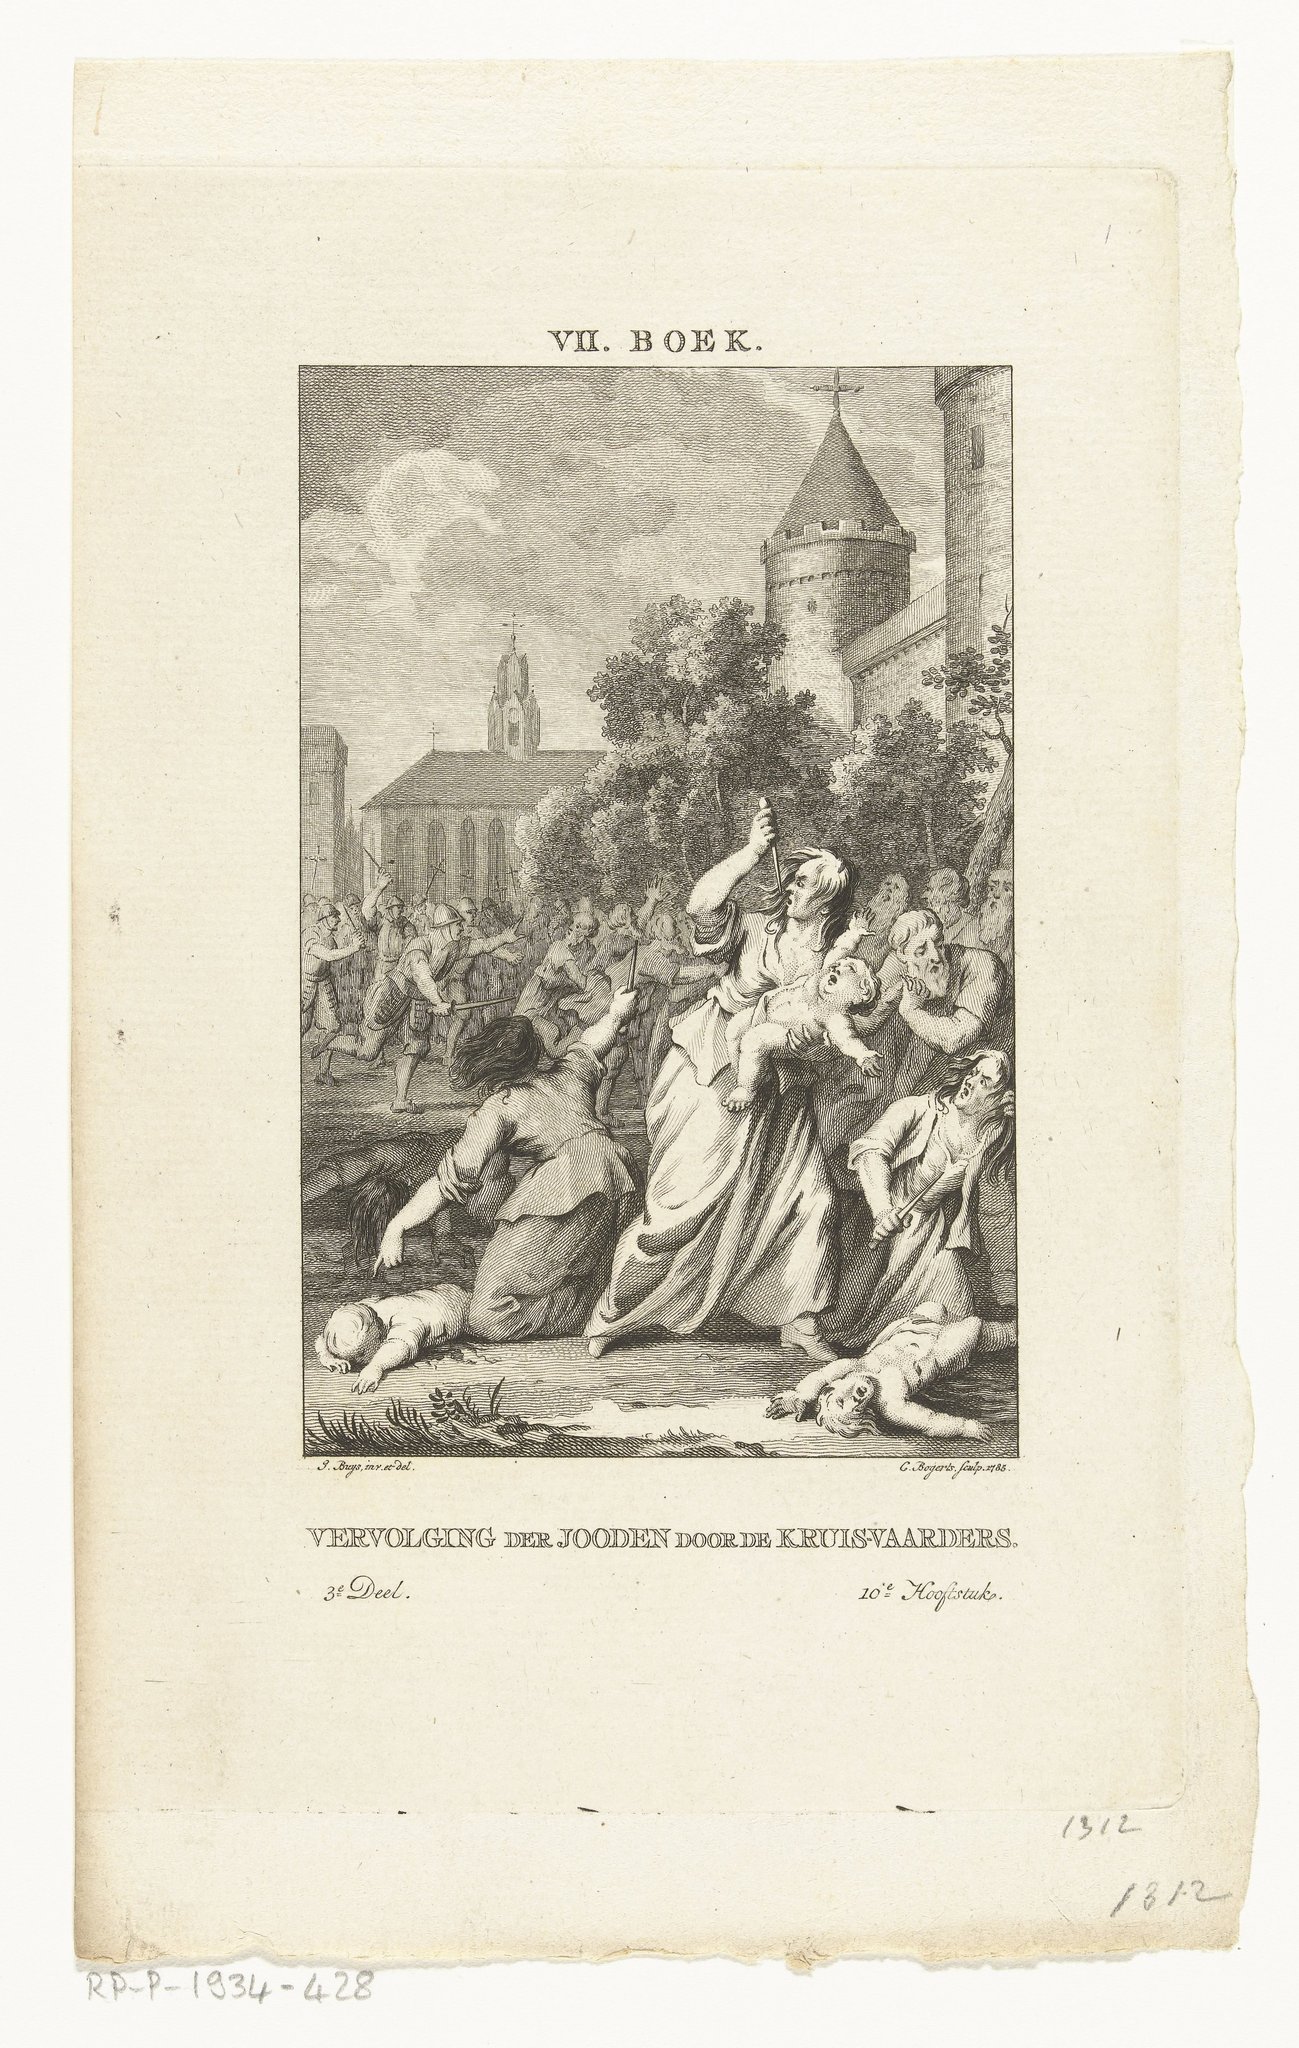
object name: book illustration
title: Jodenvervolging door de kruisridders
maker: cornelis bogerts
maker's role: print maker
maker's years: 1745-1817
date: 1784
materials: paper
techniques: etching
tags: massacre, 'pogrom' ~ anti-semitism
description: Illustratie uit: Jacques Basnage de Beauval, De historie der jooden, van den tyd van Jesus Christus tot op den tegenwoordigen tyd. Om te dienen tot een vervolg of derde deel, op de werken van Flavius Josephus. Amsterdam, J. van Gulik, 1784. 3de deel, boek VII.